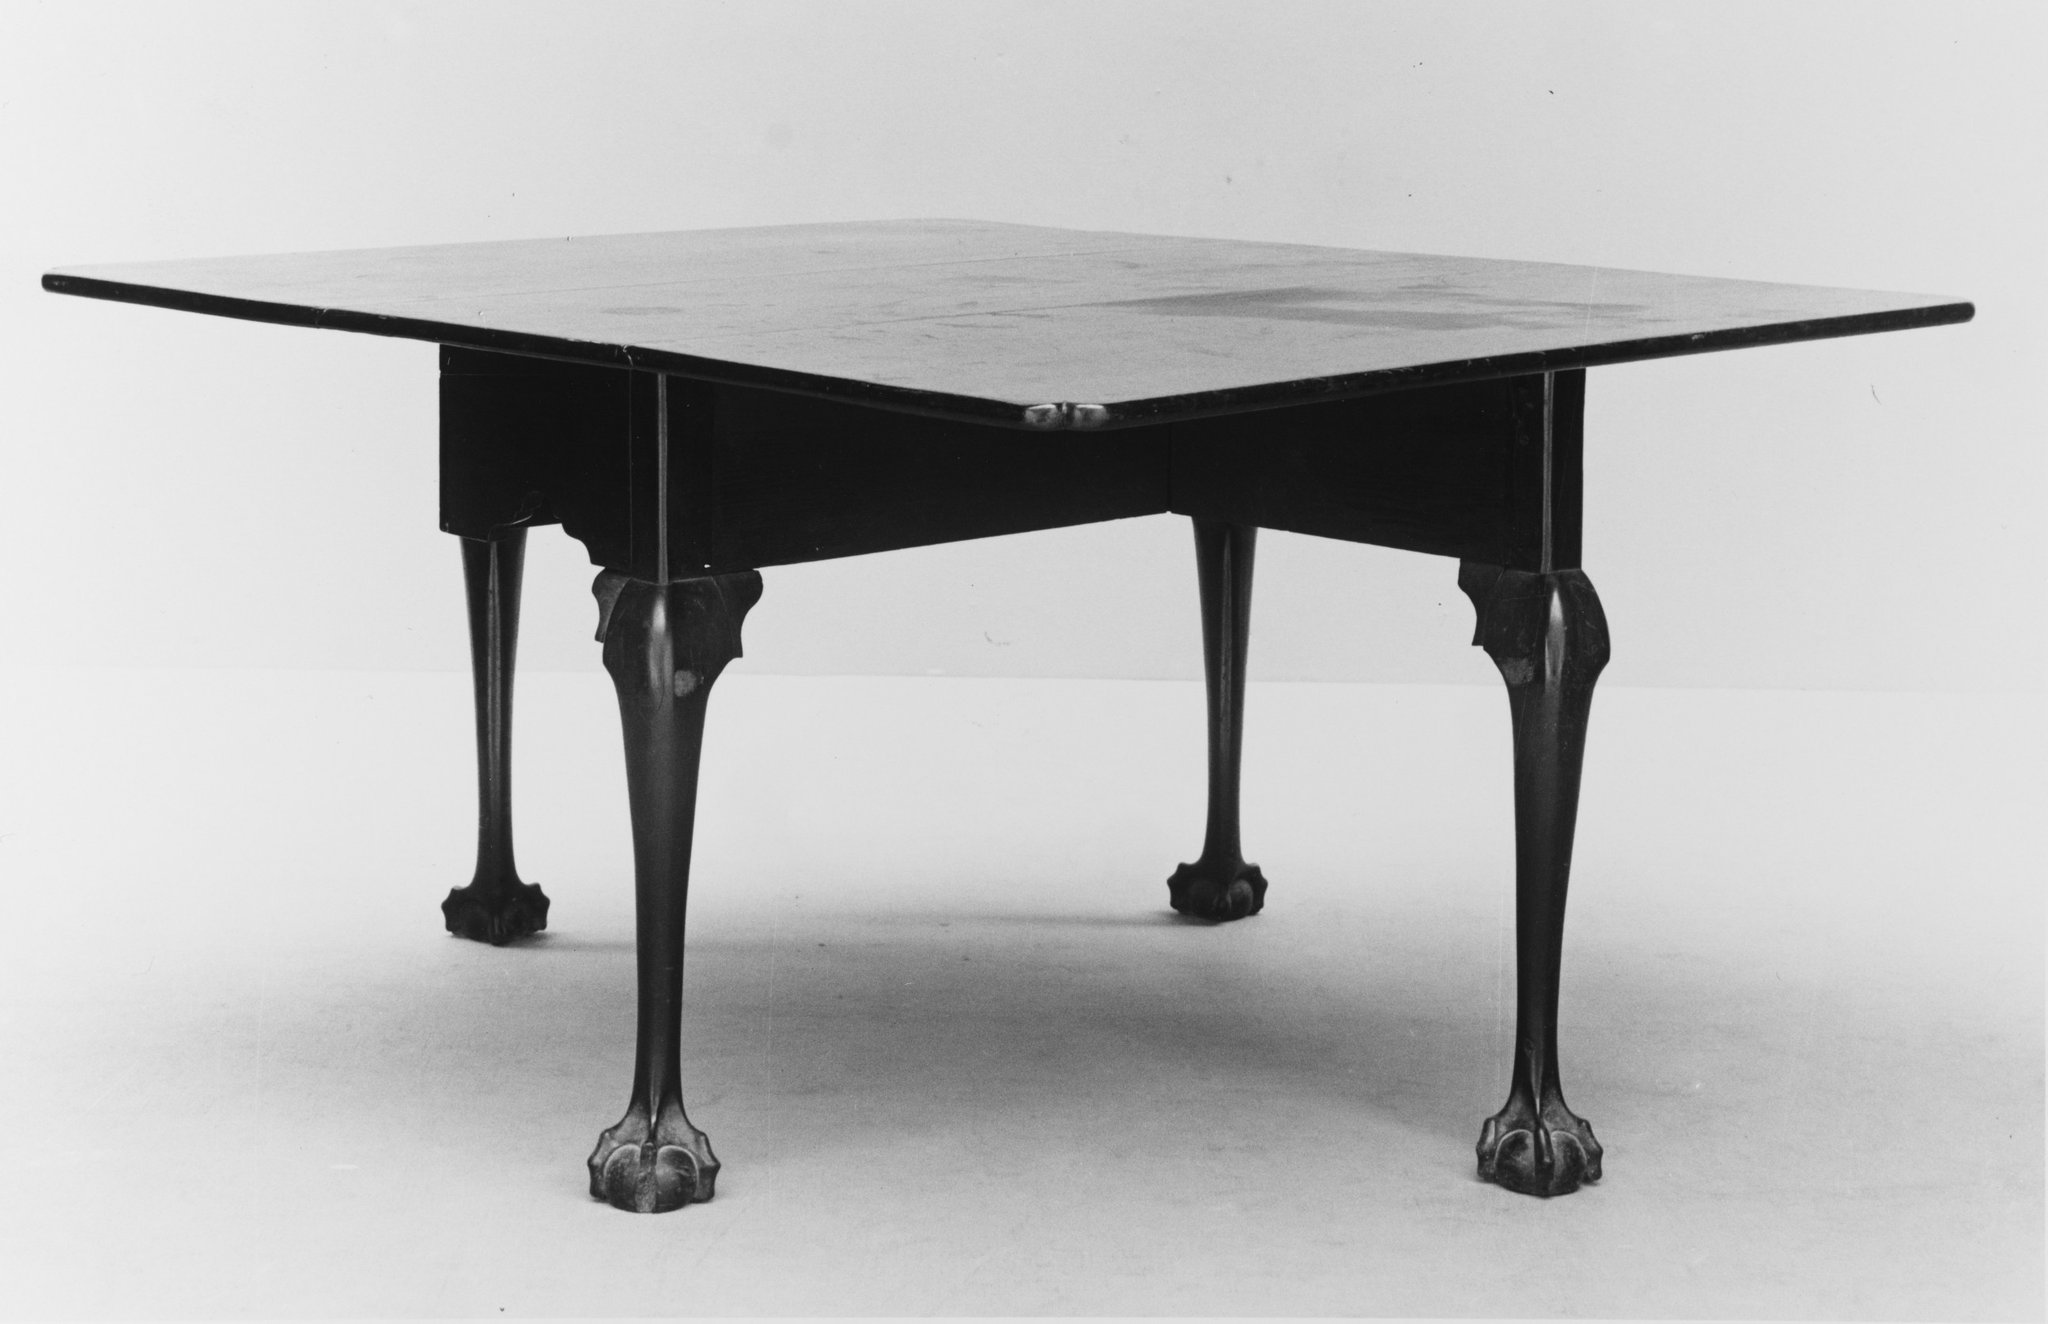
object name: drop leaf dining table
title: Drop-leaf Dining Table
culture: american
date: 1750-1790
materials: wood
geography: united states